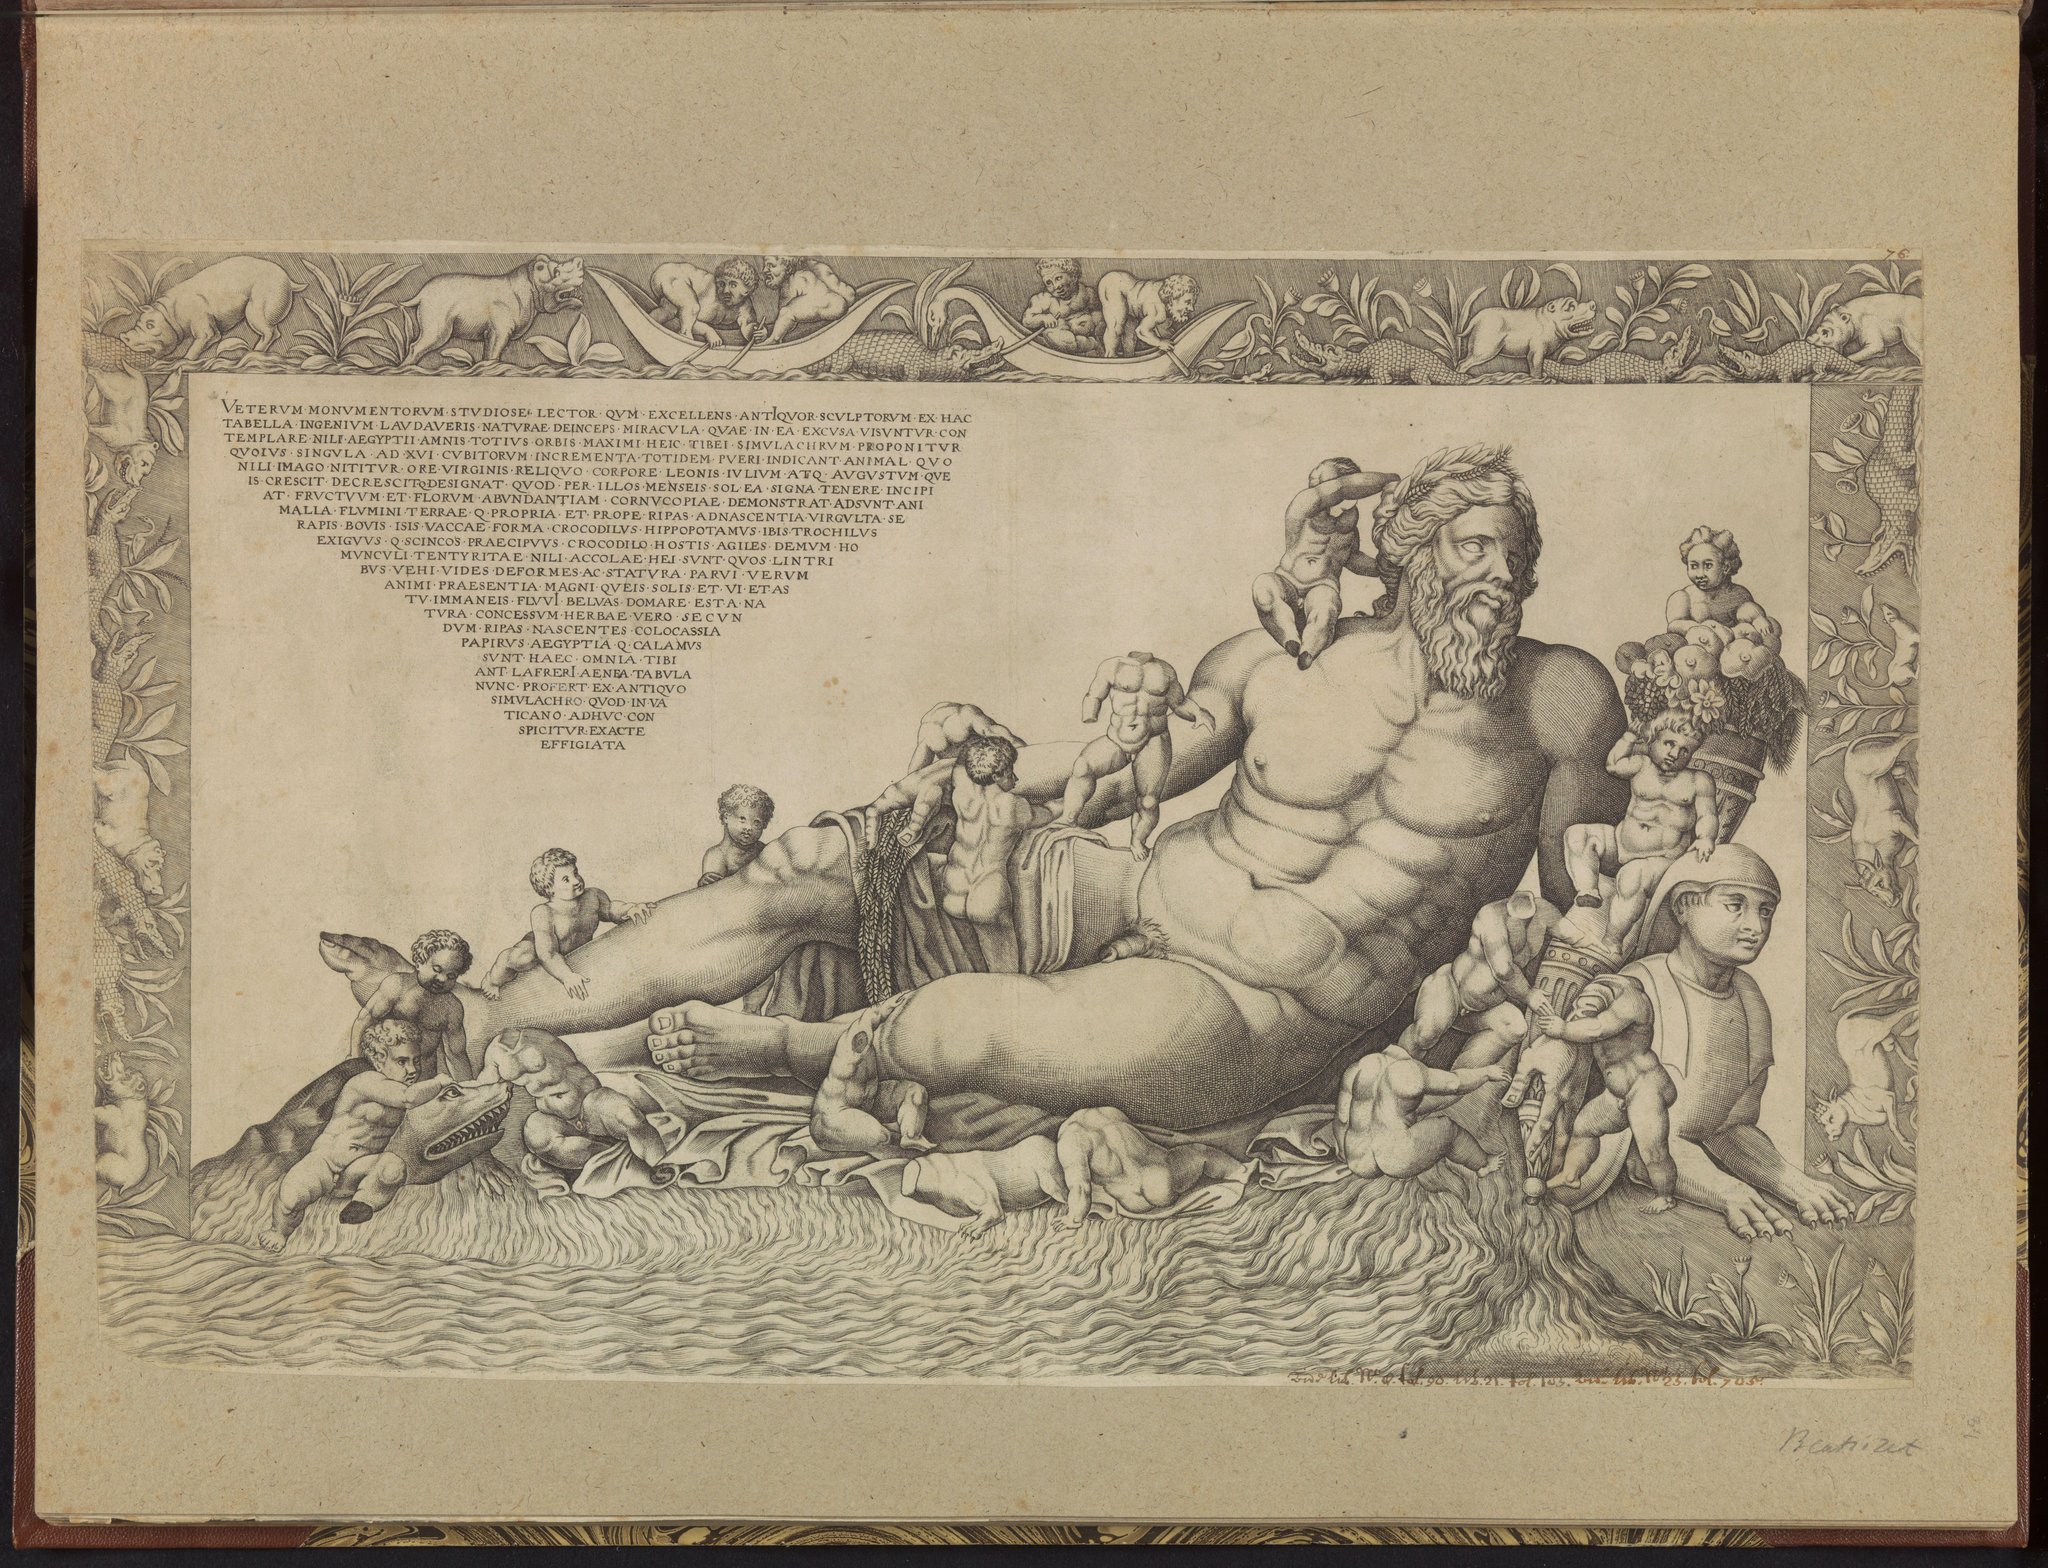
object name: album leaf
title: Sculptuur van de Nijl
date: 1525-1565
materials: paper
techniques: engraving, etching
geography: italy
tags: piece of sculpture, reproduction of a piece of sculpture, personification of river nile; 'nilo' (ripa)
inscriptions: number: ‘76’, inscription: ‘Ende lib. No. 8. fol. 90. lib. 21. fol. 103. Ende lib. No. 23. fol. 705.’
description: Sculptuur van de riviergod de Nijl met als attributen een hoorn met vruchten, een sfinx, krokodillen en kleine jongetjes. Rond de voorstelling een lijst met voorstellingen van krokodillen, nijlpaarden, ossen en kleine mannetjes in boten. De prent maakt deel uit van een album.